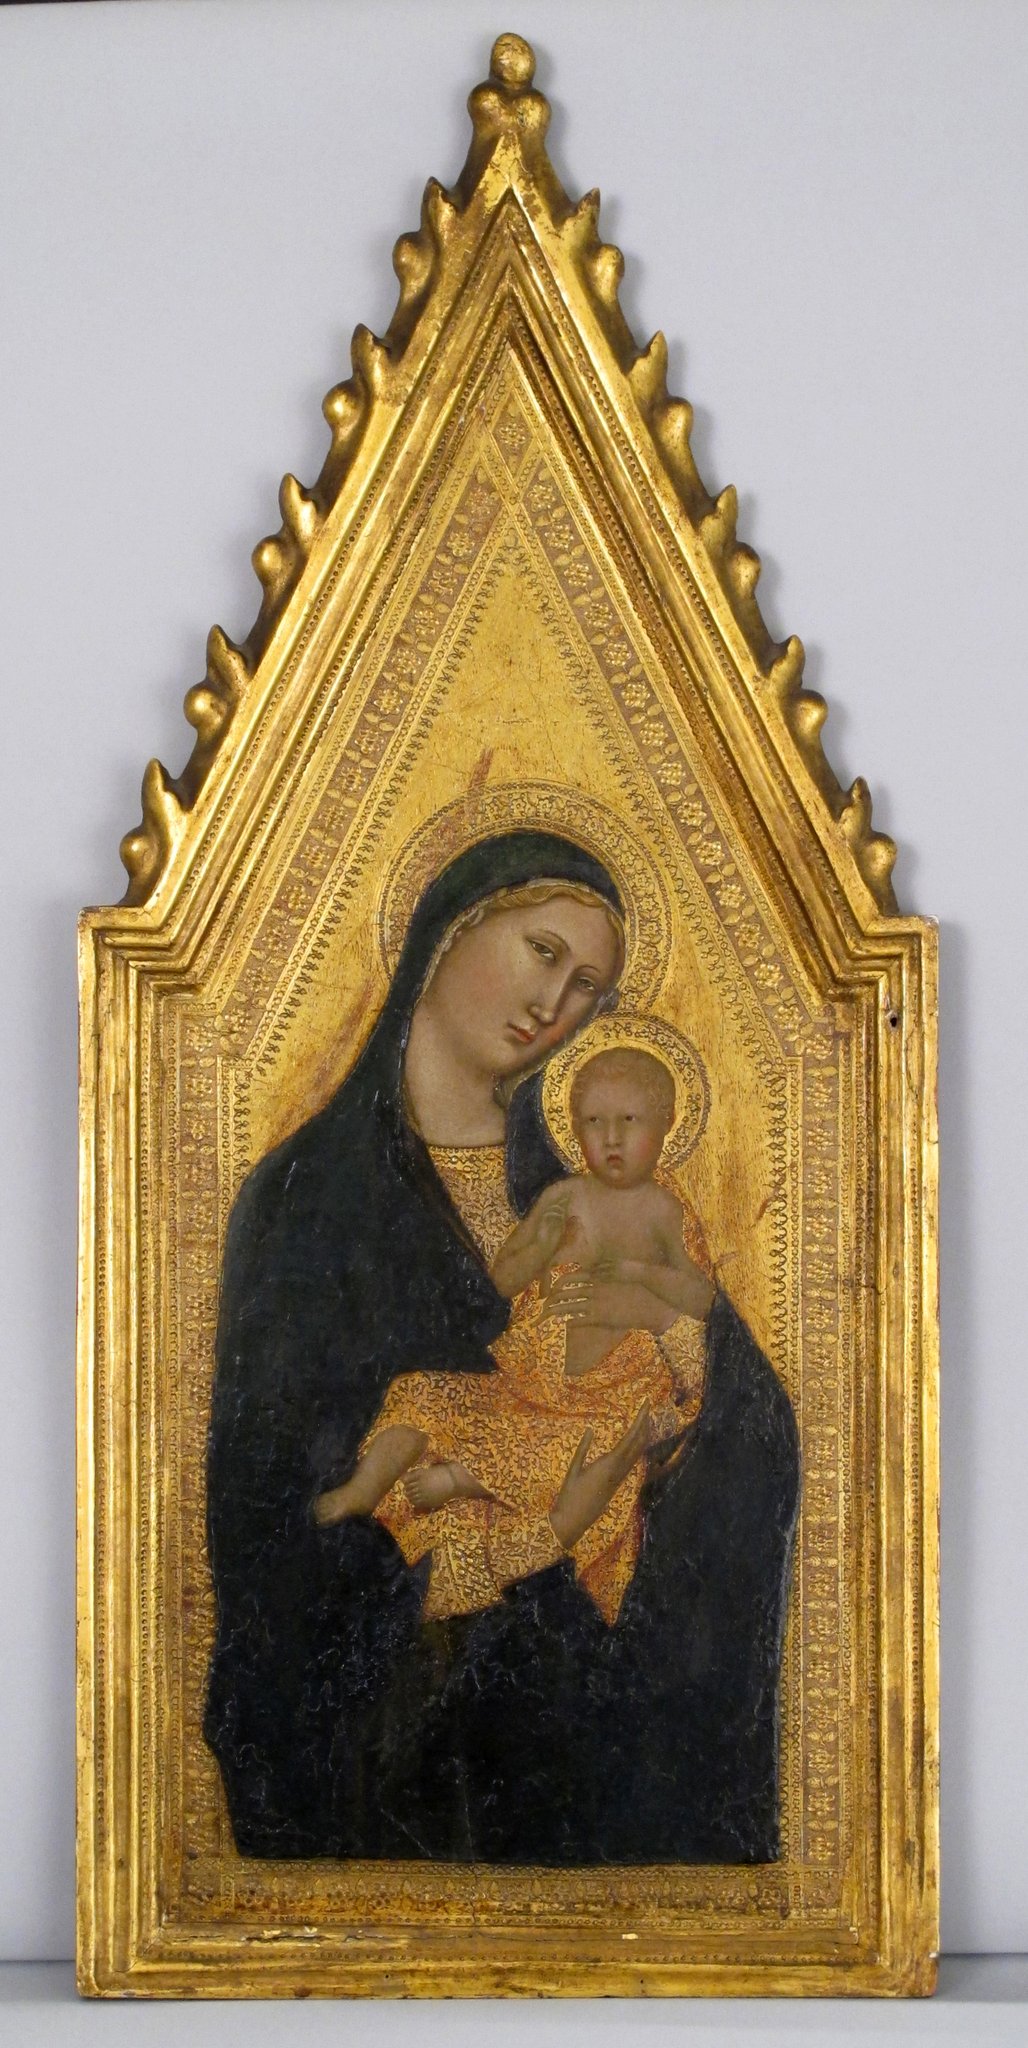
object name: painting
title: Madonna and Child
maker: barna da siena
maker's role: artist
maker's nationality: italian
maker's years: 1325-1375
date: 1340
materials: gold leaf, paint, wood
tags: madonna and child